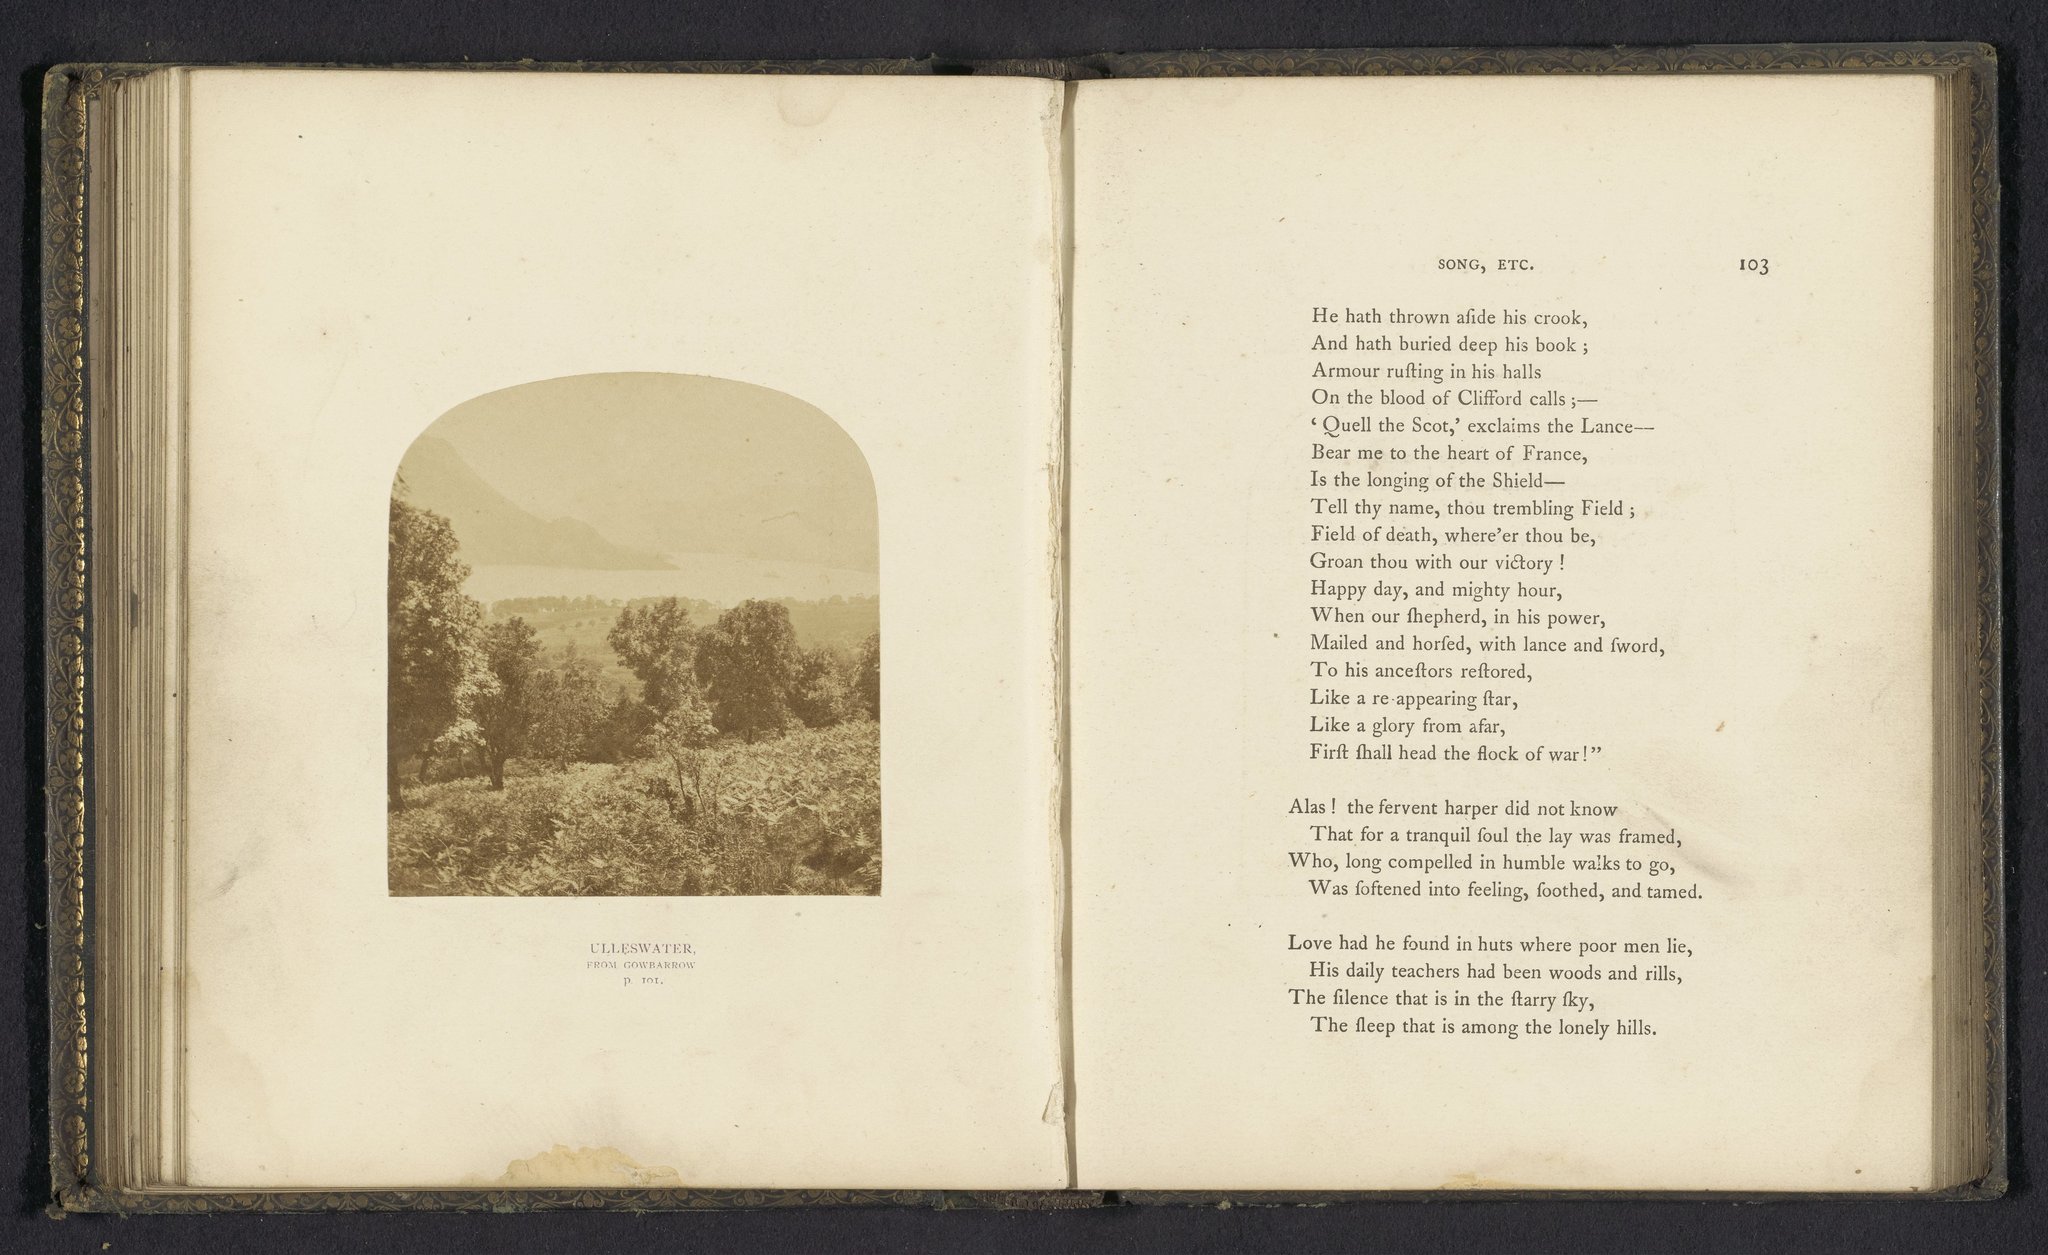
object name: page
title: Ulleswater, from Cowbarrow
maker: thomas ogle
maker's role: fotograaf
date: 1860-1870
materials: photographic support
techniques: albumen print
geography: gowbarrow fell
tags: lake